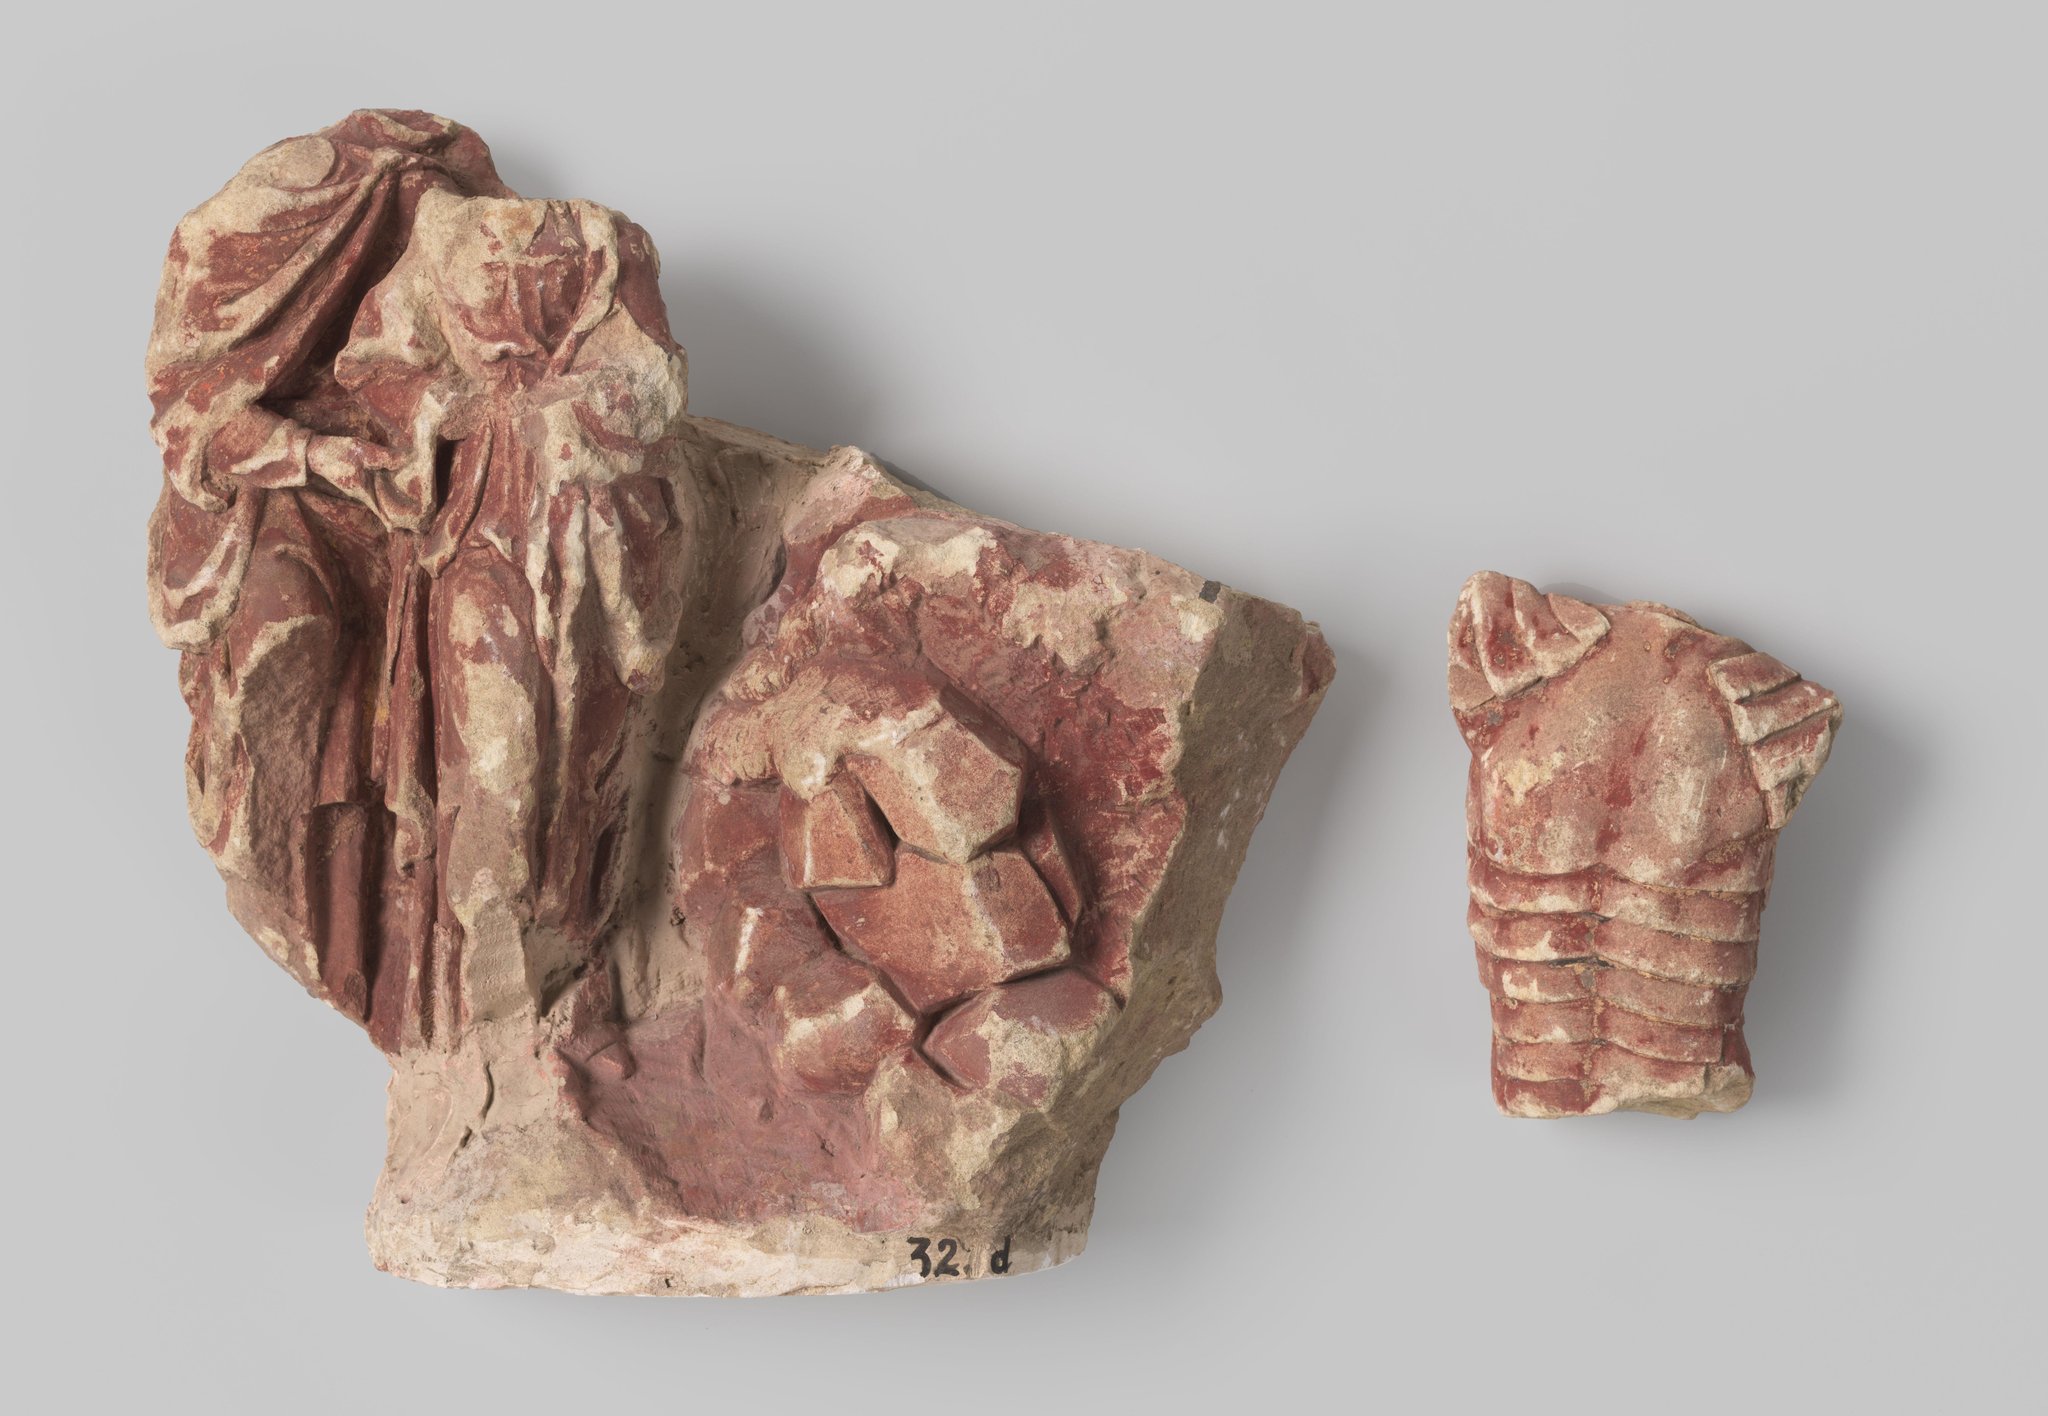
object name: epitaaf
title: Epitaaf, voorstellende de Kruisiging, opgegraven te Utrecht bij het oude Minderbroederklooster (fragmenten)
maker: Anonymous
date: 1500-1525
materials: stone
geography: utrecht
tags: minderbroedersklooster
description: Twee fragmenten van een beeldgroep die waarschijnlijk in het epitaaf gestaan heeft. Donkerrood gekleurd. De groep moet een kruisiging hebben voorgesteld. Het grootste fragment stelt voor Johannes Maria wegleidende, rechts hiervan op de achtergrond krijgslieden te paard. Opgegraven te Utrecht bij het oude Minderbroederklooster.